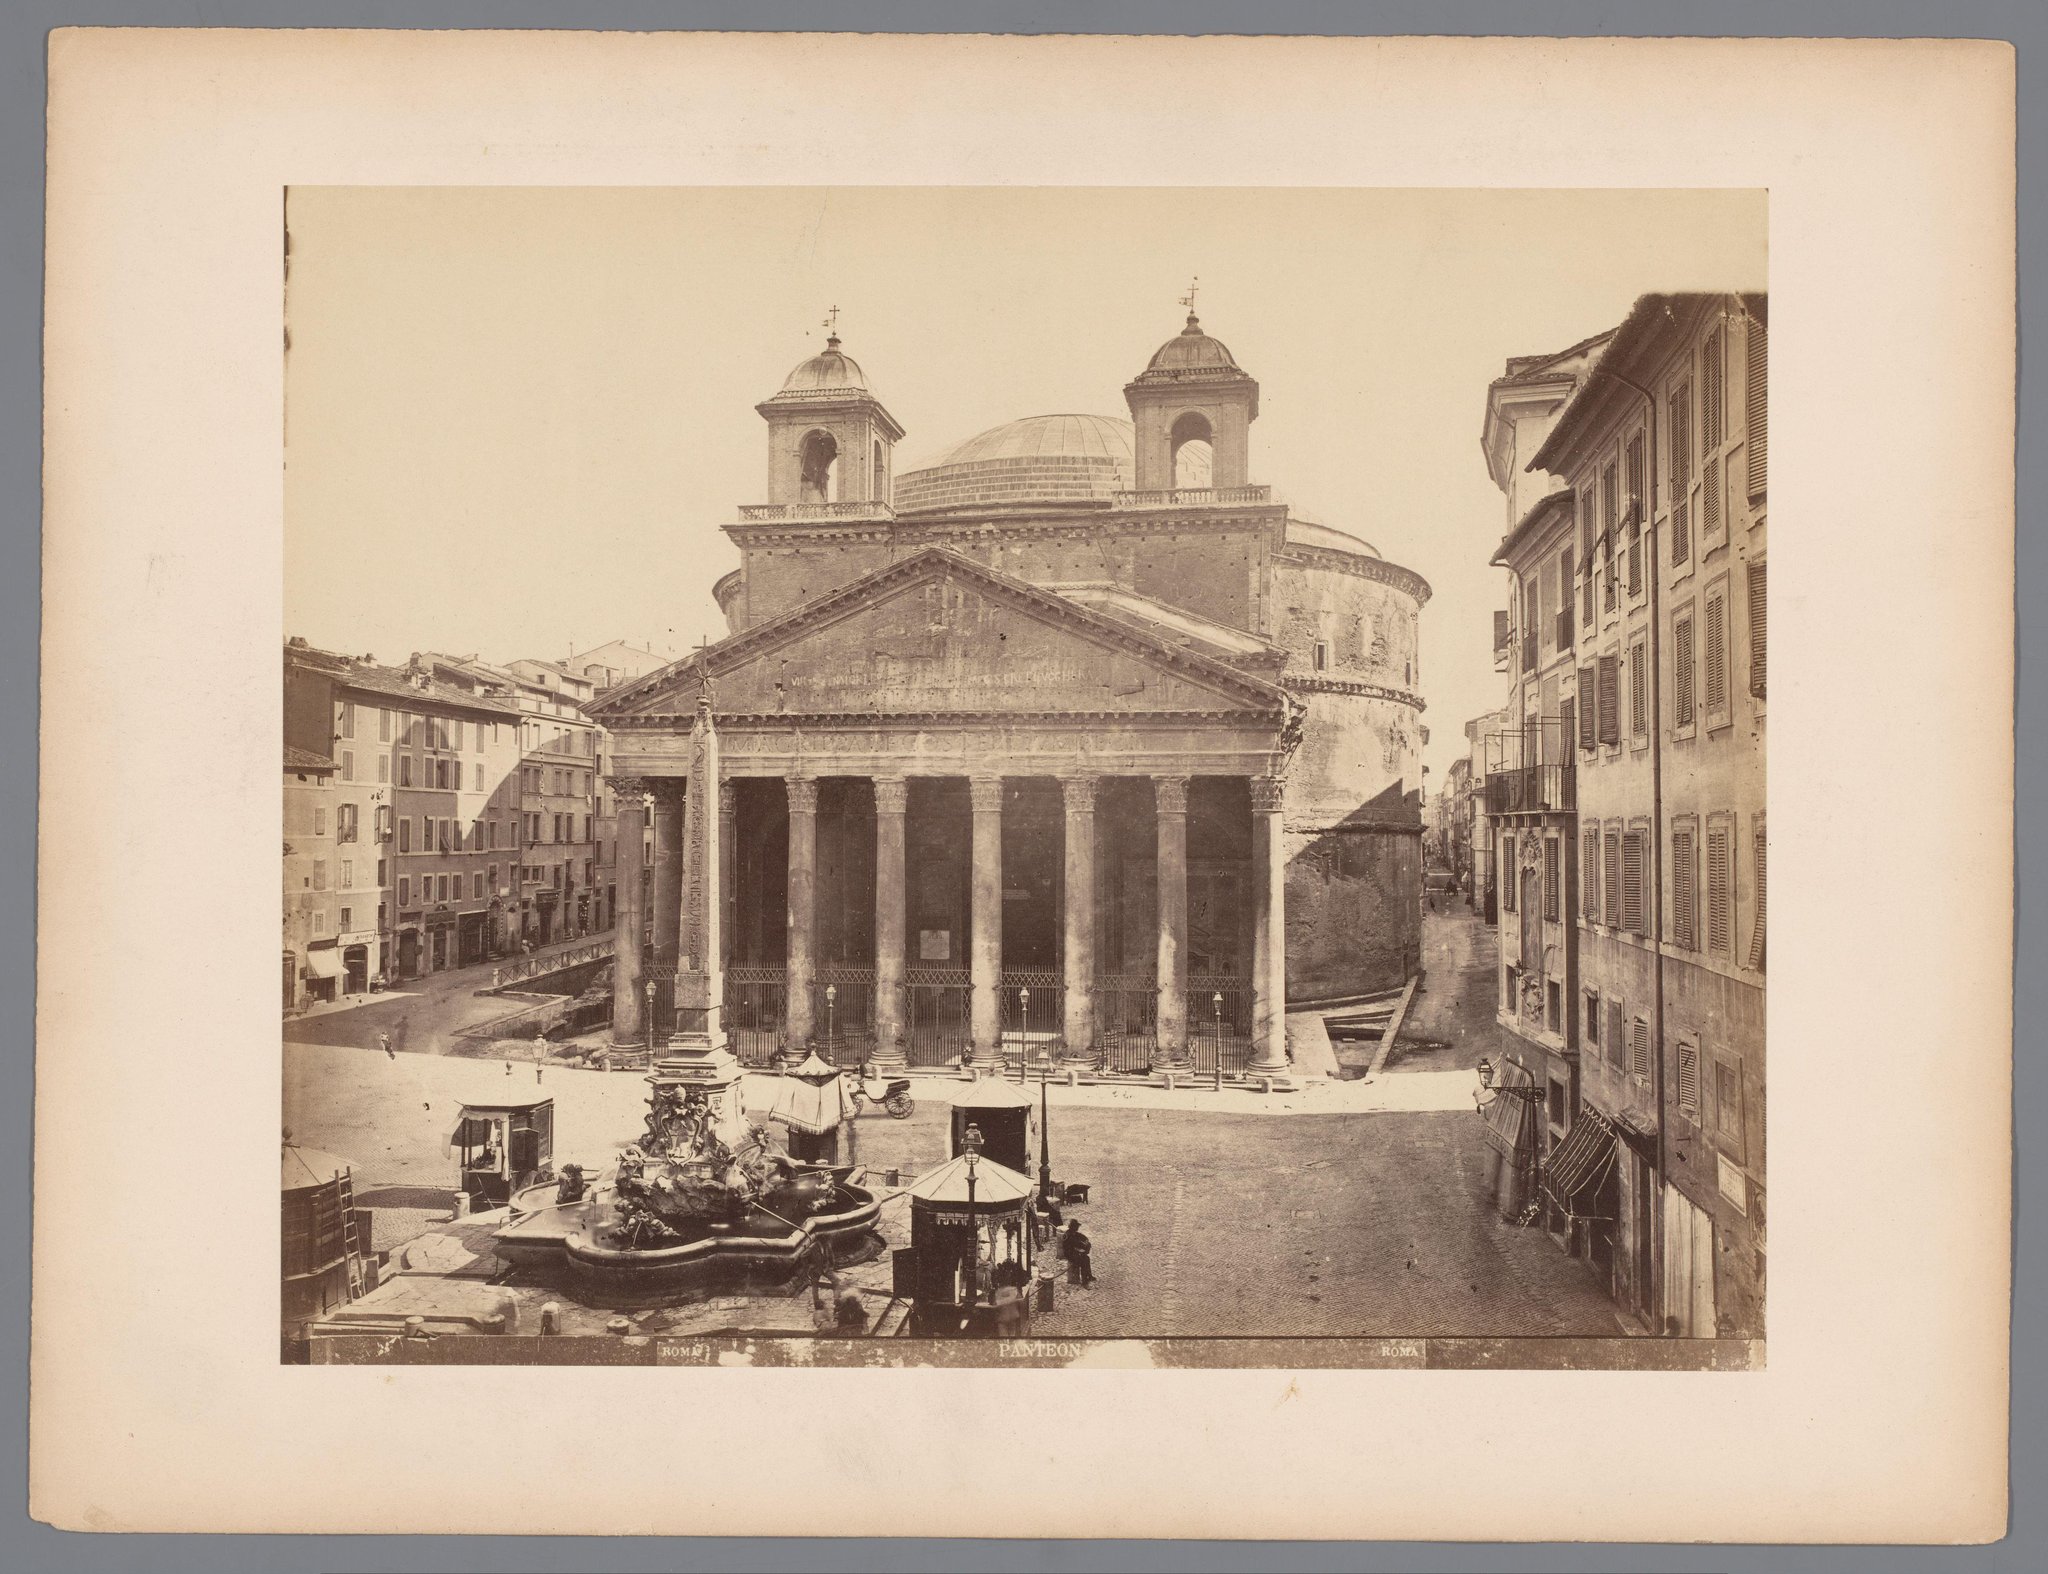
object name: photograph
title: Roma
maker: Anonymous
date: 1851-1900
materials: cardboard, paper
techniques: albumen print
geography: rome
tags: square, place, circus, etc., obelisk, needle, church (exterior)